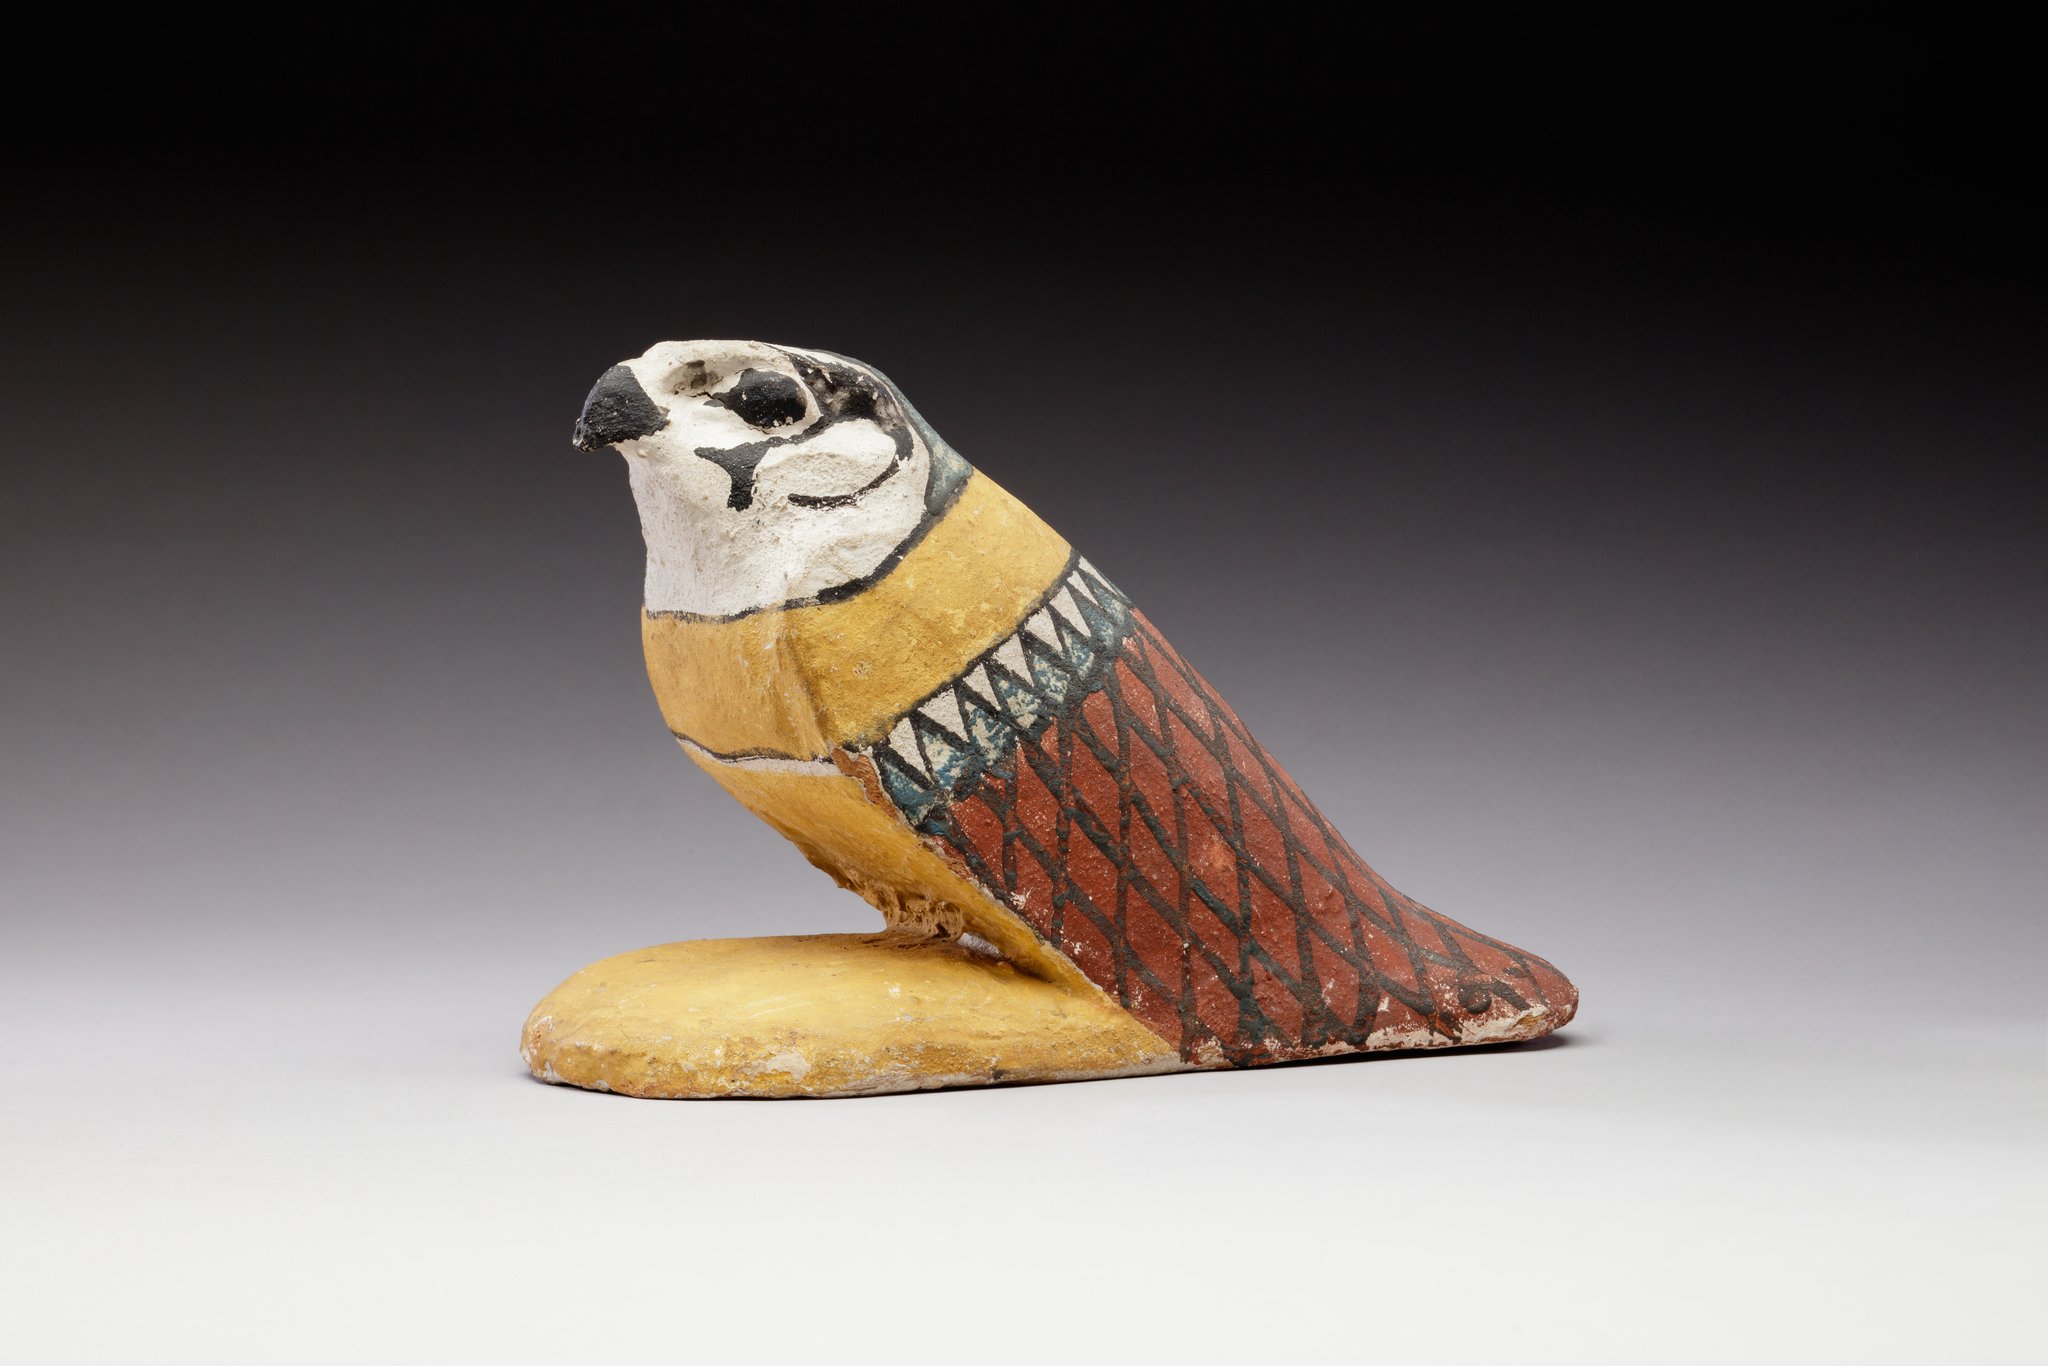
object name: figurine, falcon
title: Falcon figurine from a coffin or box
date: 664-332 BCE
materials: gesso, paint, wood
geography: egypt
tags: falcons